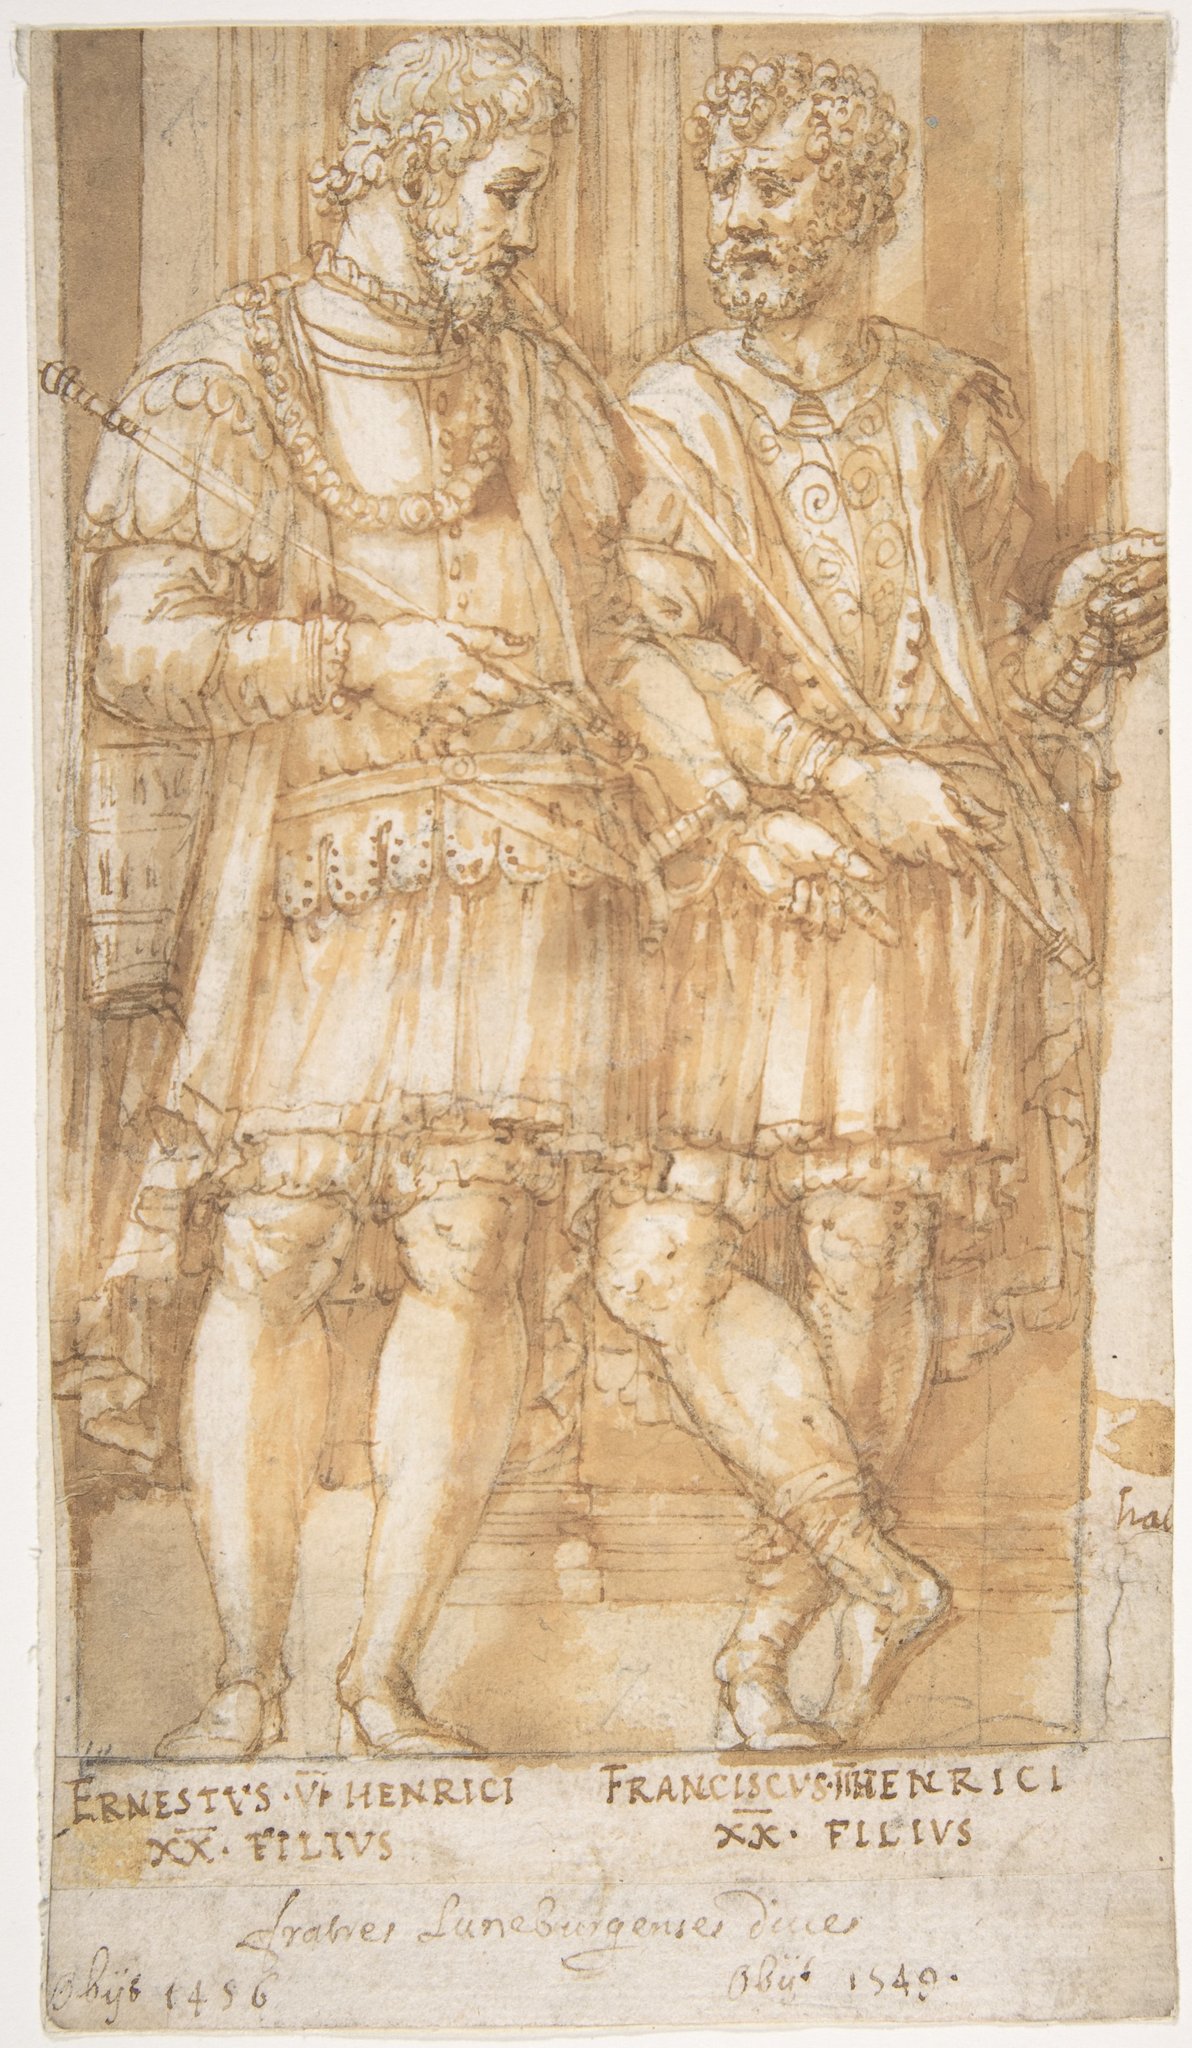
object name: drawing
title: Two Princes of the House of Este: Ernest VI and Francis II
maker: pirro ligorio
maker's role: artist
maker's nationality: italian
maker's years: 1512-1583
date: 1513-1583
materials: chalk, ink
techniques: brush, pen, wash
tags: princes